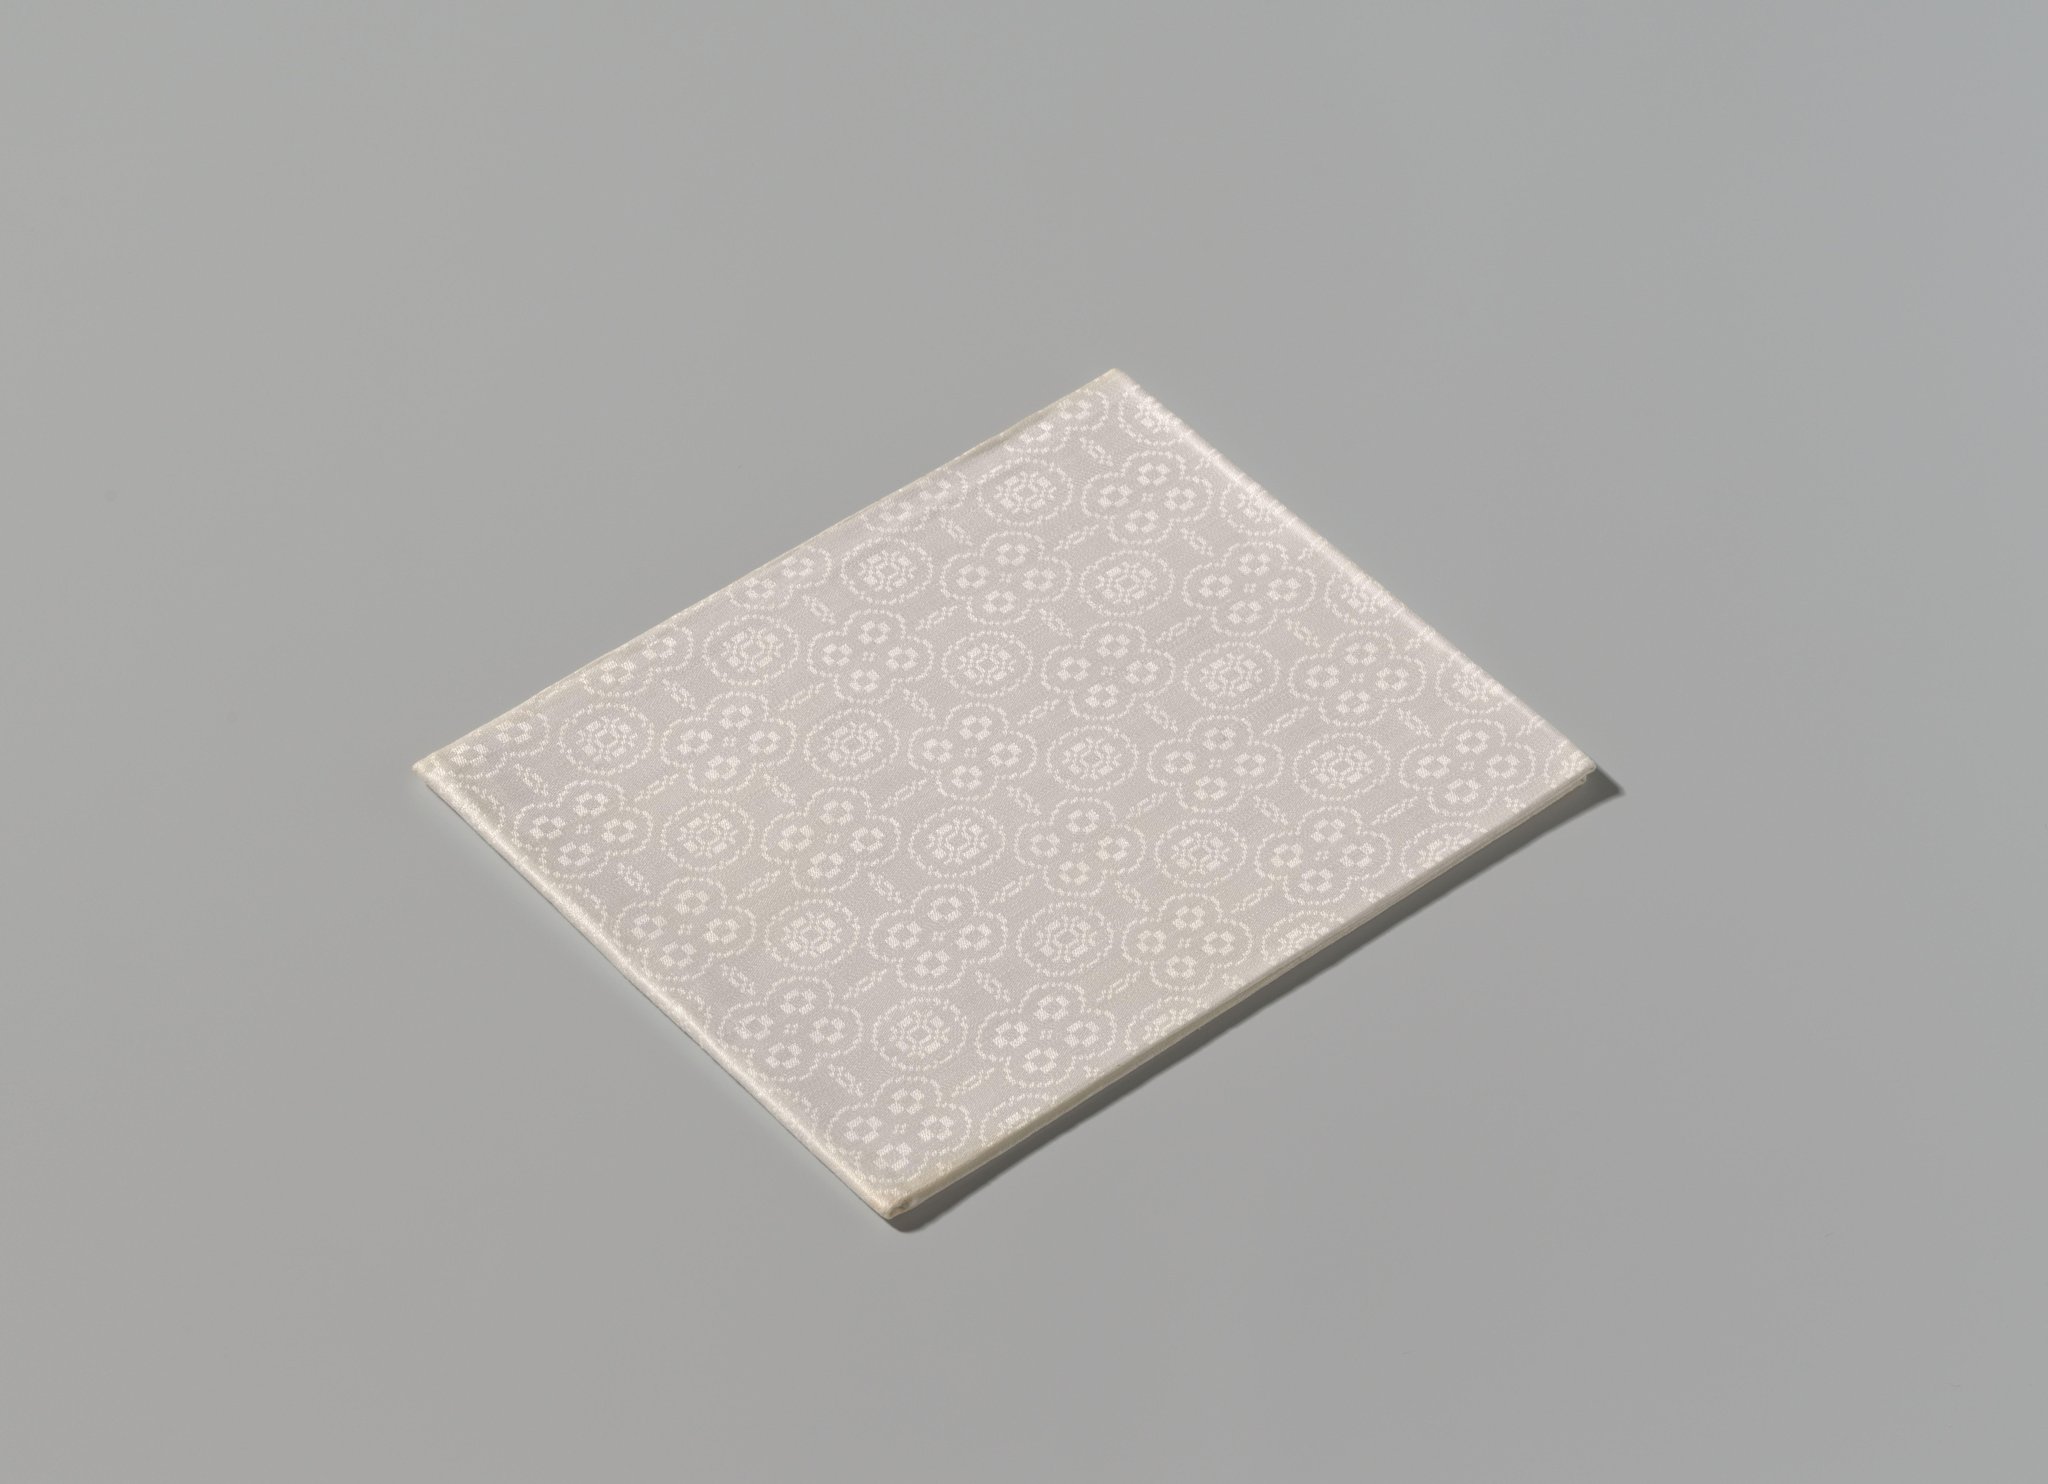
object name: napkin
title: Wit linnen pellen servet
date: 1700-1725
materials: linen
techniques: peeled fabric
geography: northern netherlands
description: Wit linnen pellen servet, gemerkt (KK?) R28. Bijgemaakt bij BK 1980-415?